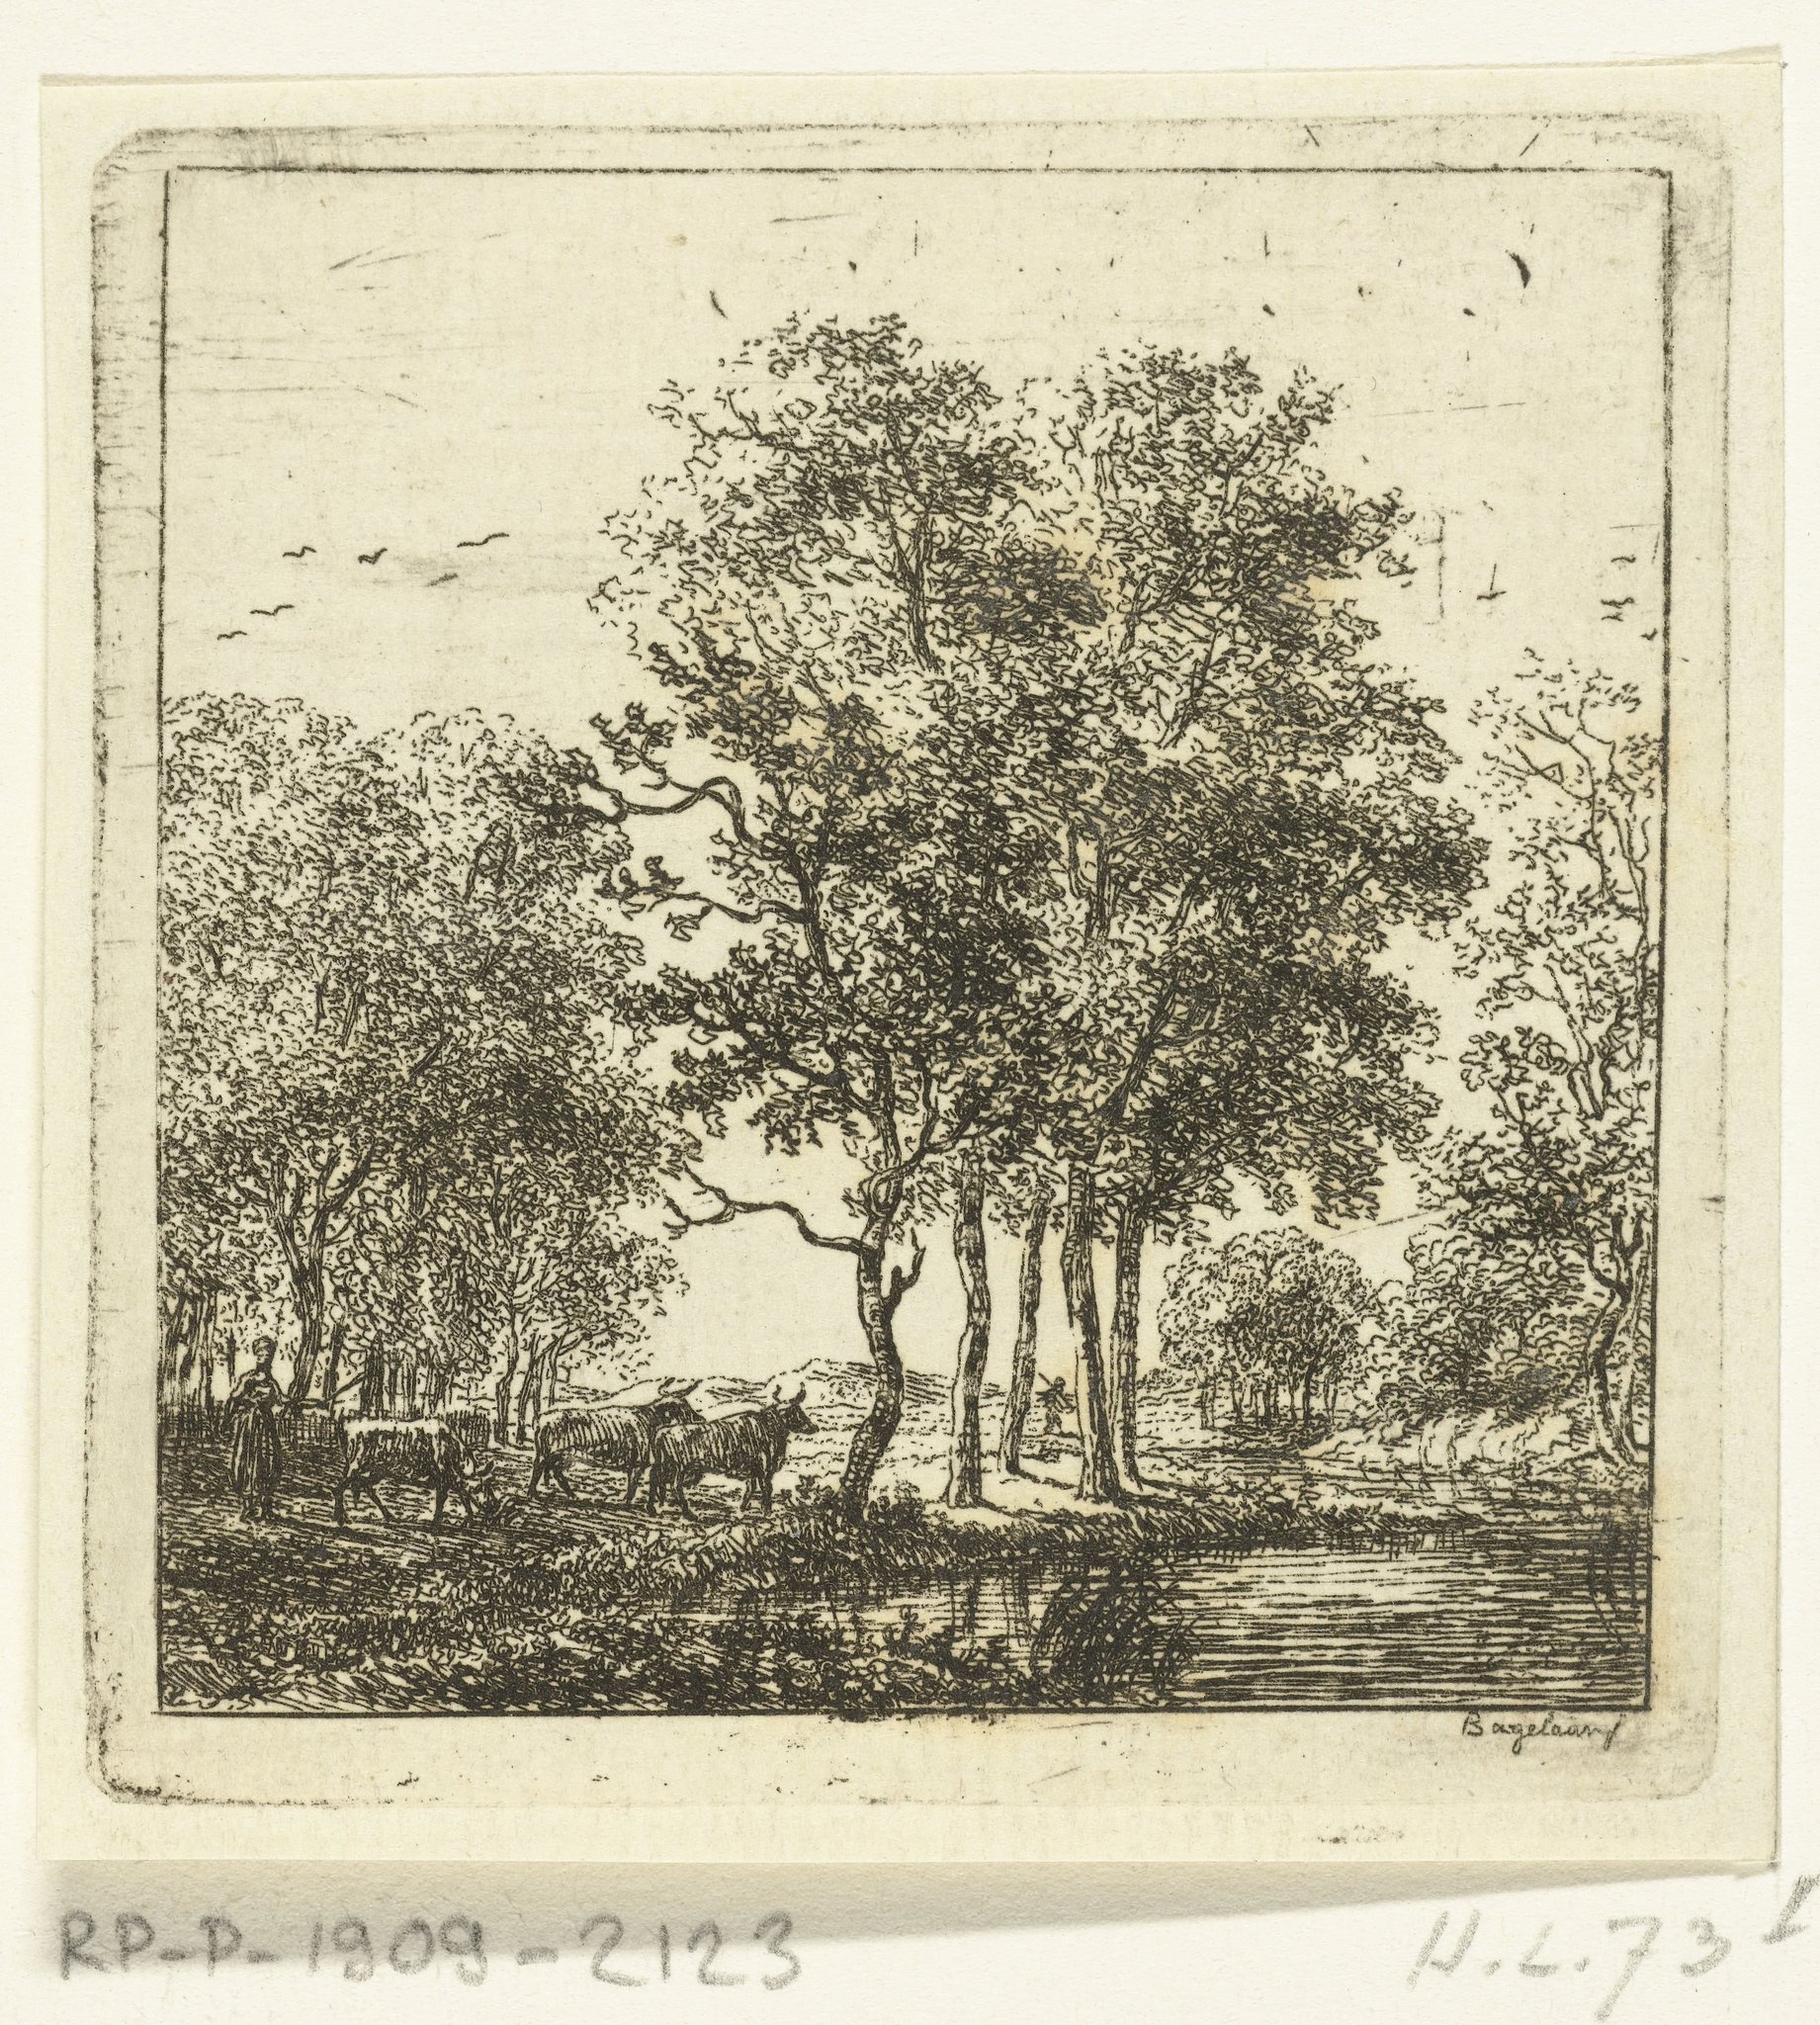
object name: print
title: Drie koeien bij een rivier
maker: ernst willem jan bagelaar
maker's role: draughtsman, print maker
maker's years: 1775-1837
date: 1798-1837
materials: paper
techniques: etching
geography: netherlands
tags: landscapes with waters, waterscapes, seascapes (in the temperate zone) (+ landscape with figures, staffage)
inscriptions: collector's mark: Lugt 2228